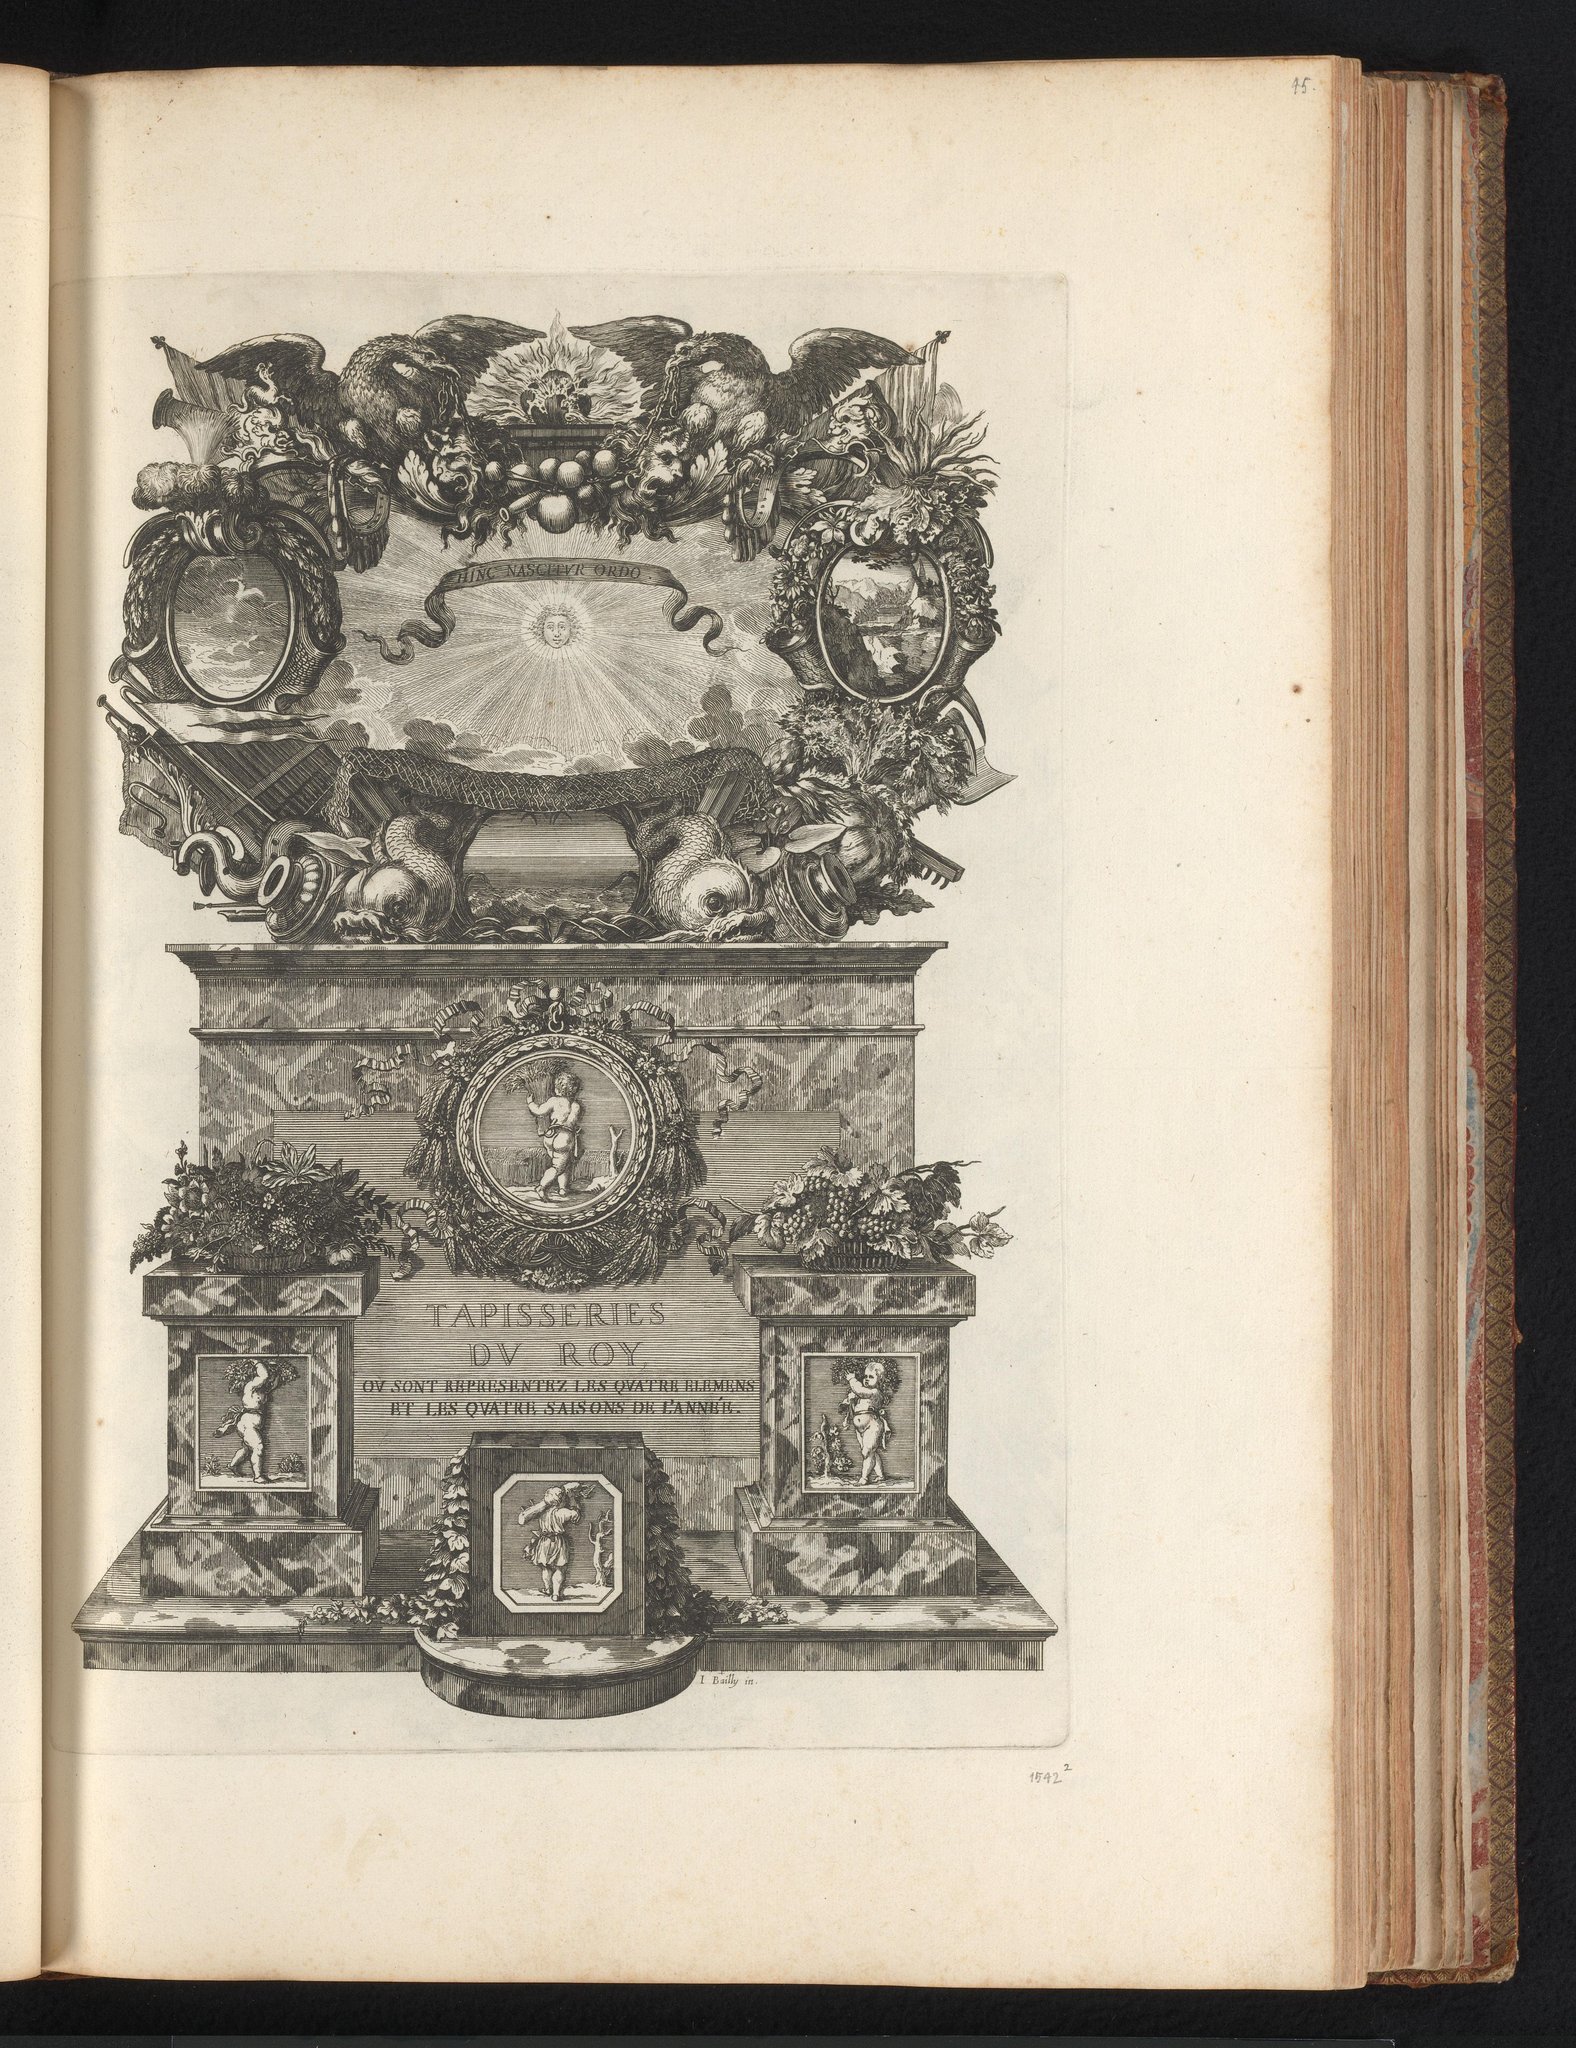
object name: album leaf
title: Sokkels met daarop de vier elementen en de vier seizoenen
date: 1670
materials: paper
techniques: engraving, etching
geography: paris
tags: lodewijk xiv (koning van frankrijk), the four elements, and ether, the fifth element, tapestry, cupids: 'amores', 'amoretti', 'putti', king, the four seasons of the year ~ human activities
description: Titelpagina voor: Félibien, André. Devises pour les tapisseries du Roy, où sont représentez les quatre éléments et les quatre saisons de l'année (...). Parijs: Imprimerie Royale, 1670.